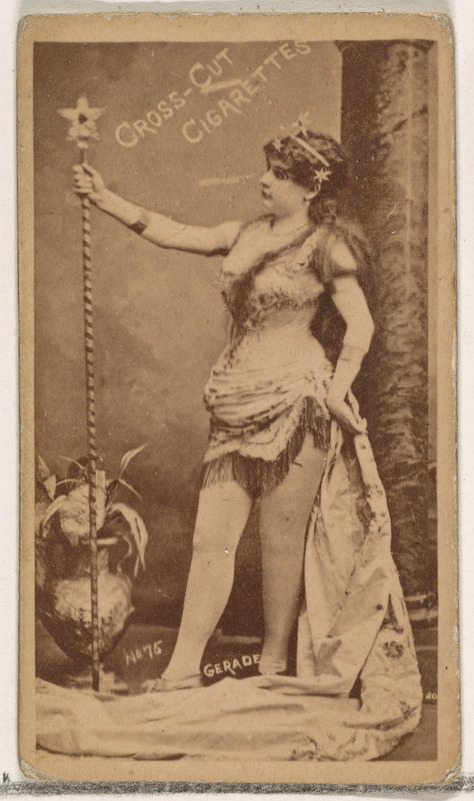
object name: print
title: Card Number 75, Gerade, from the Actors and Actresses series (N145-1) issued by Duke Sons & Co. to promote Cross Cut Cigarettes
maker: w. duke, sons & co.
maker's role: publisher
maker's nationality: american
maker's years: 1870-1920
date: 1880-1889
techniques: albumen silver print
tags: women,actresses